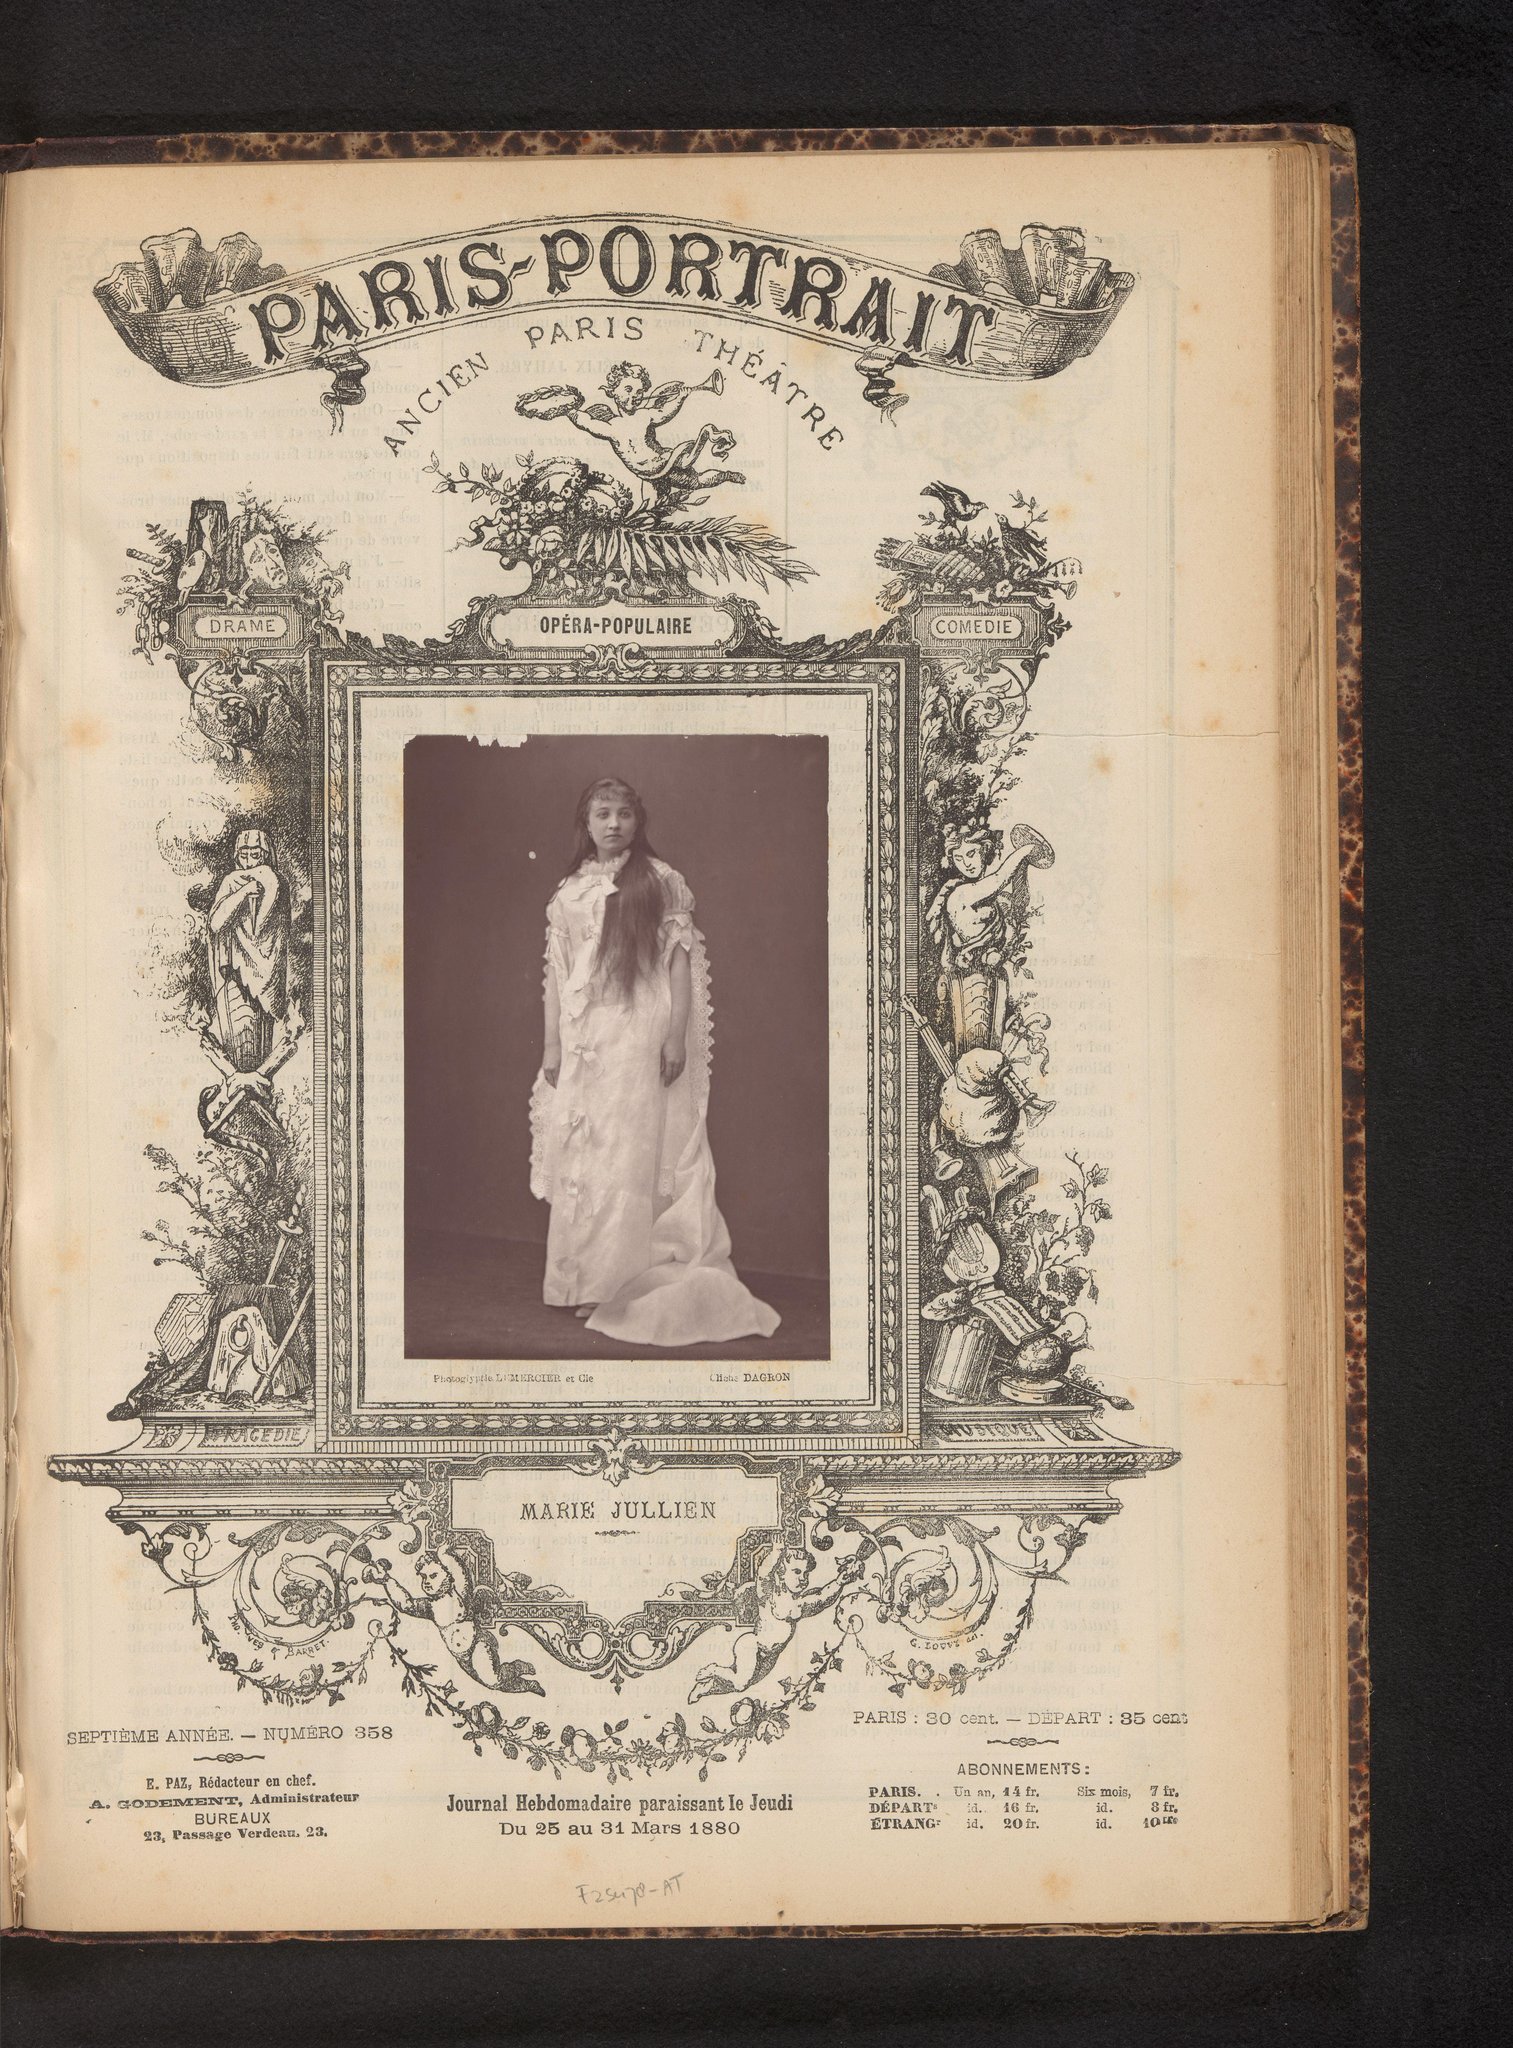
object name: photomechanical print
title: Marie Jullien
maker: prudent rené-patrice dagron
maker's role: fotograaf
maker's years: 1819-1900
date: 1873-1880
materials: paper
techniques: woodburytype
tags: historical persons - bb - woman